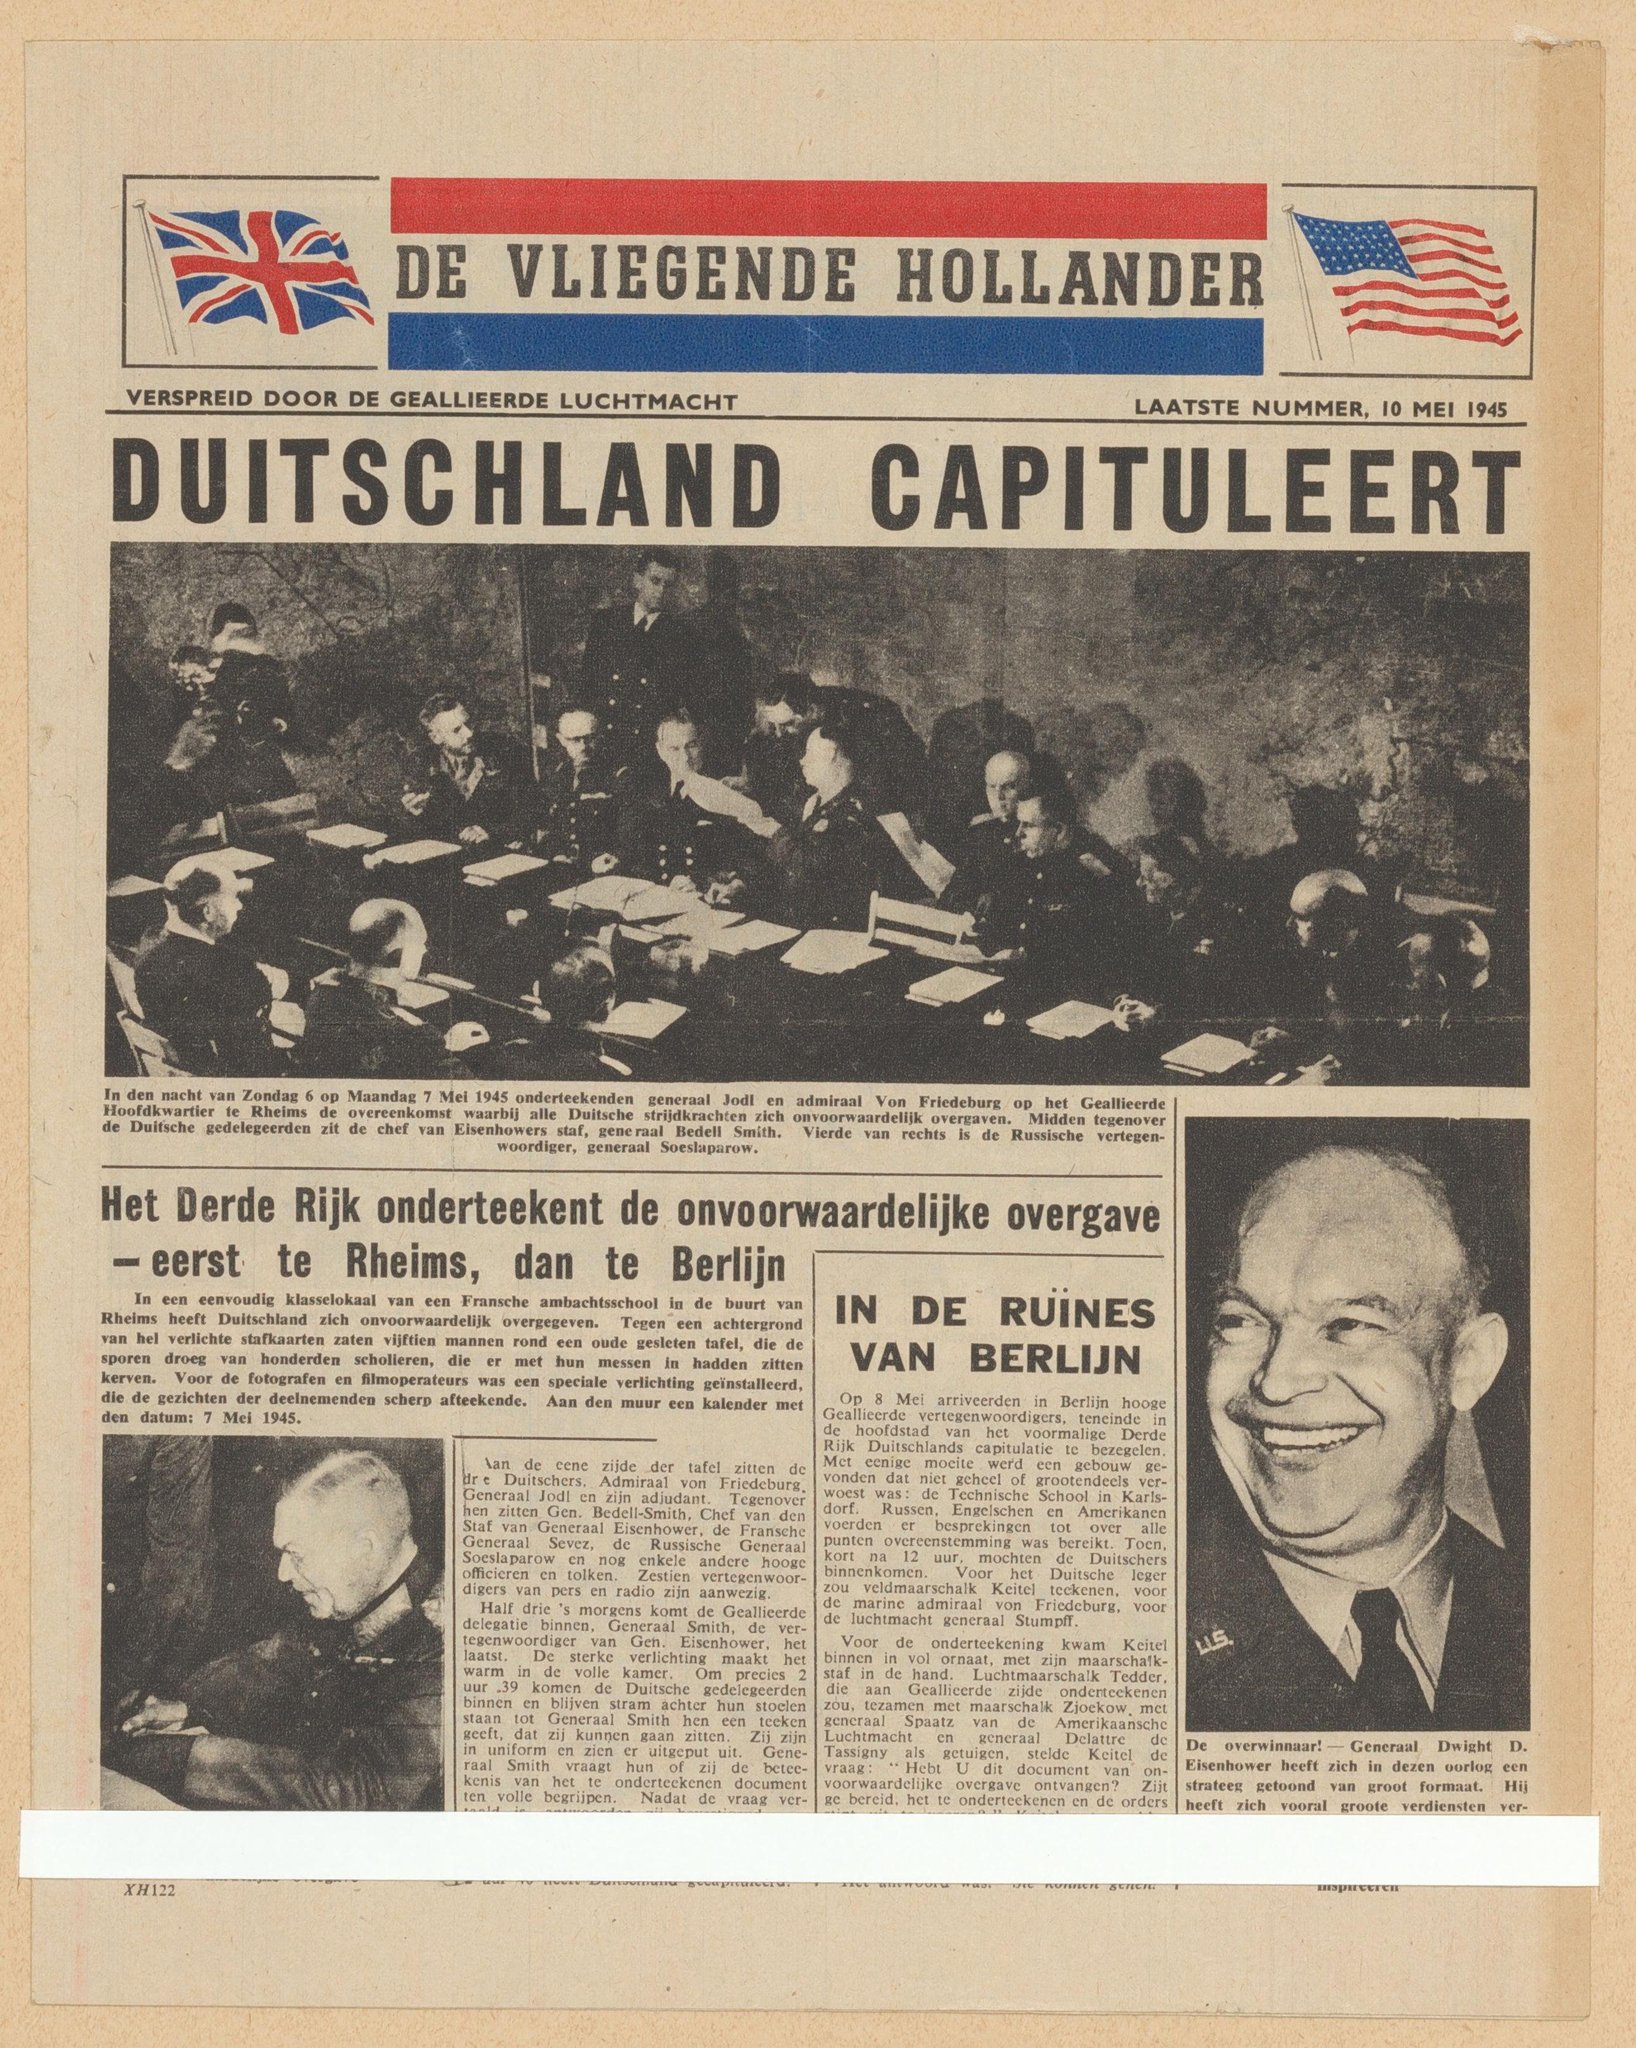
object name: photomechanical print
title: De Vliegende Hollander, laatste nummer, 10 mei 1945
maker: Anonymous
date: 1945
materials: paper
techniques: printing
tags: political propaganda, newspaper, news-sheet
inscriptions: collector's mark, collector's mark: Lugt 1641